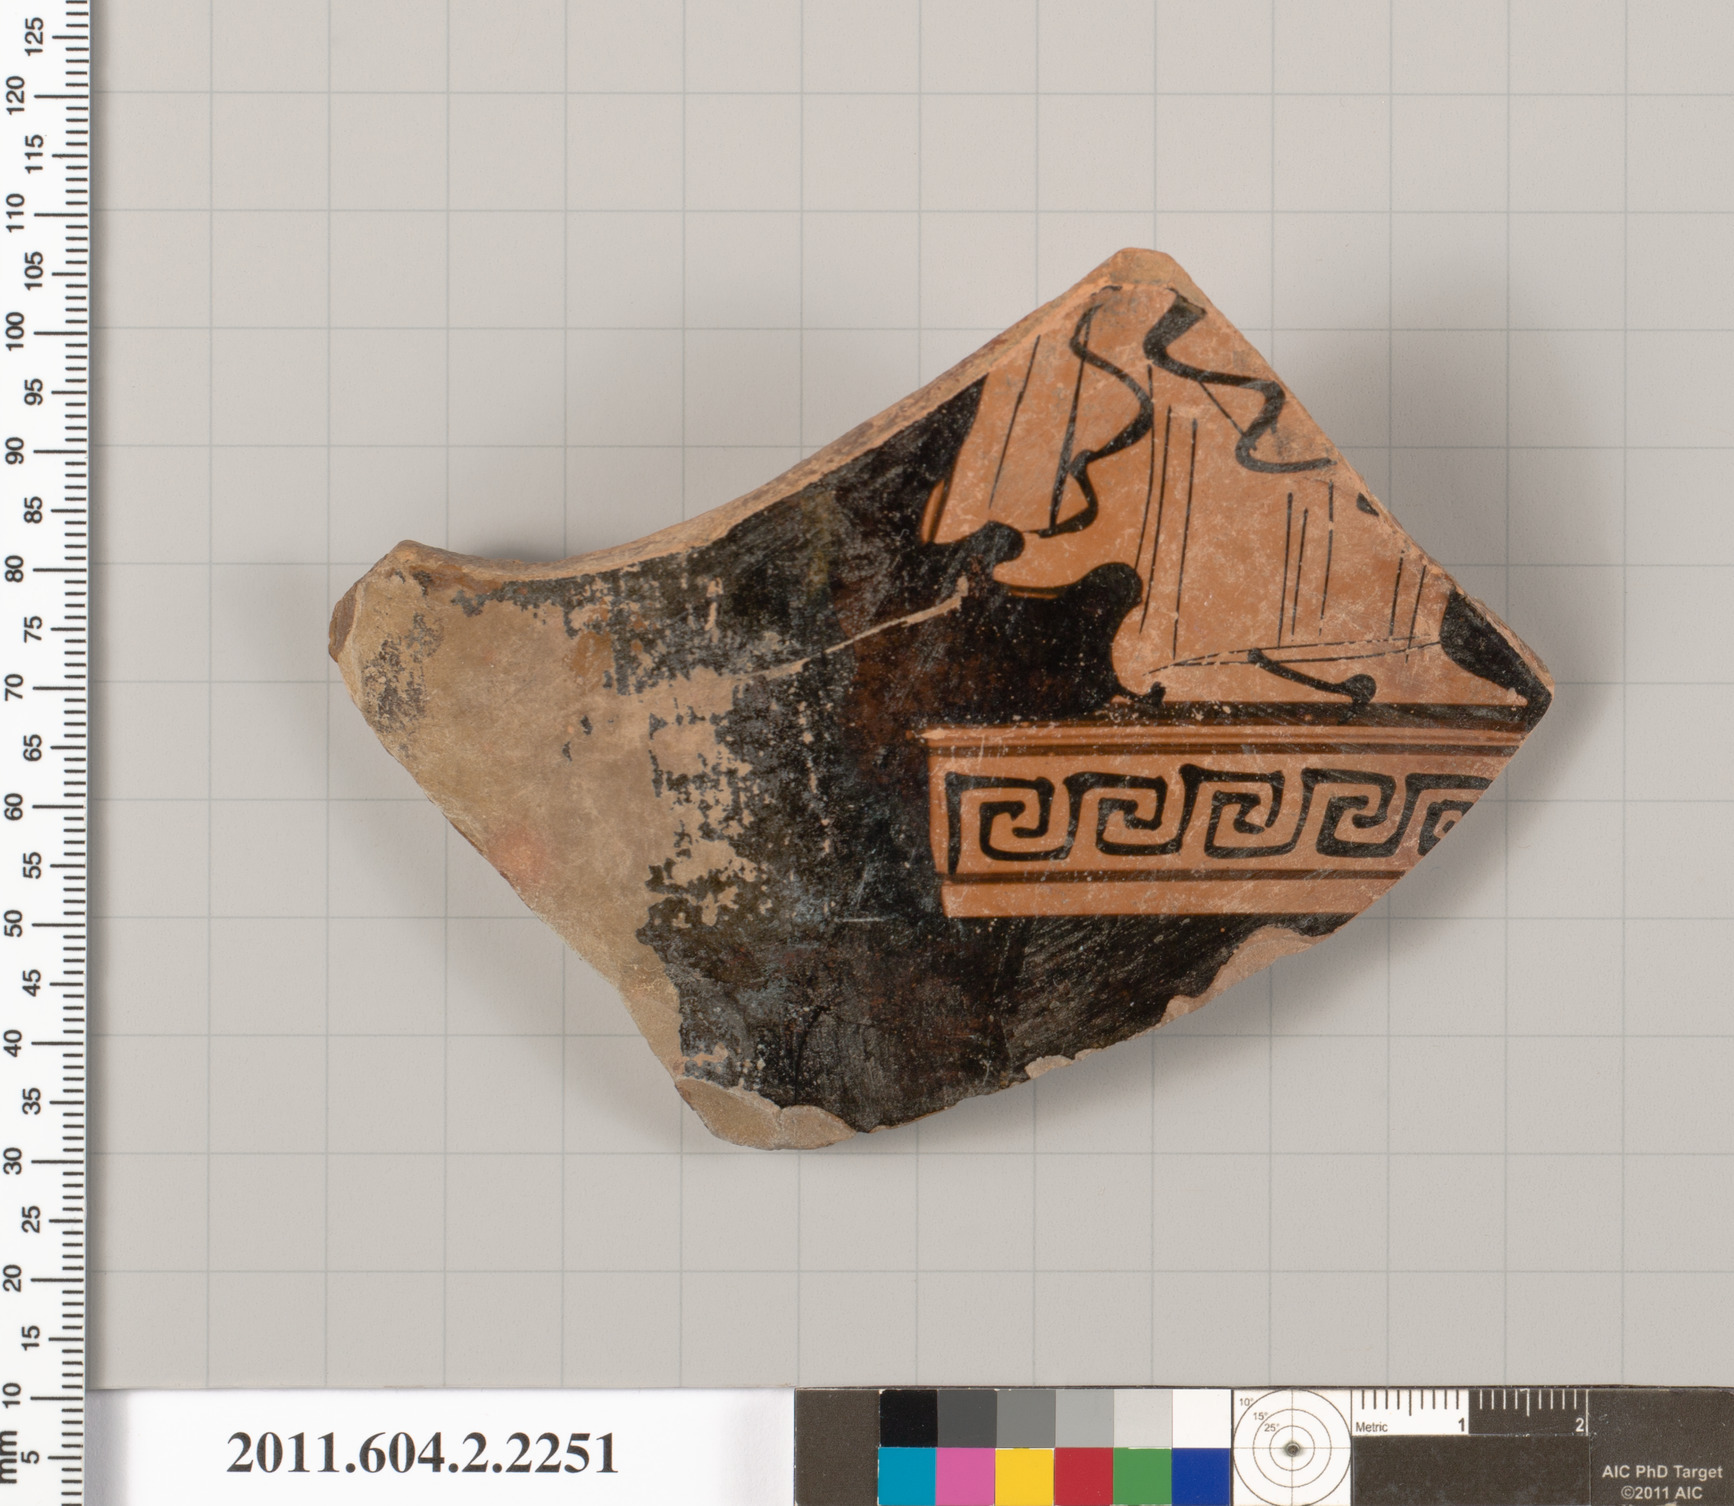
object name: amphora fragment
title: Terracotta fragment of an amphora (jar)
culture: greek, attic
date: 460-440 BCE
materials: terracotta